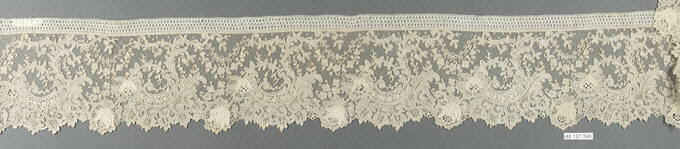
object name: border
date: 1851-1900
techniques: lace